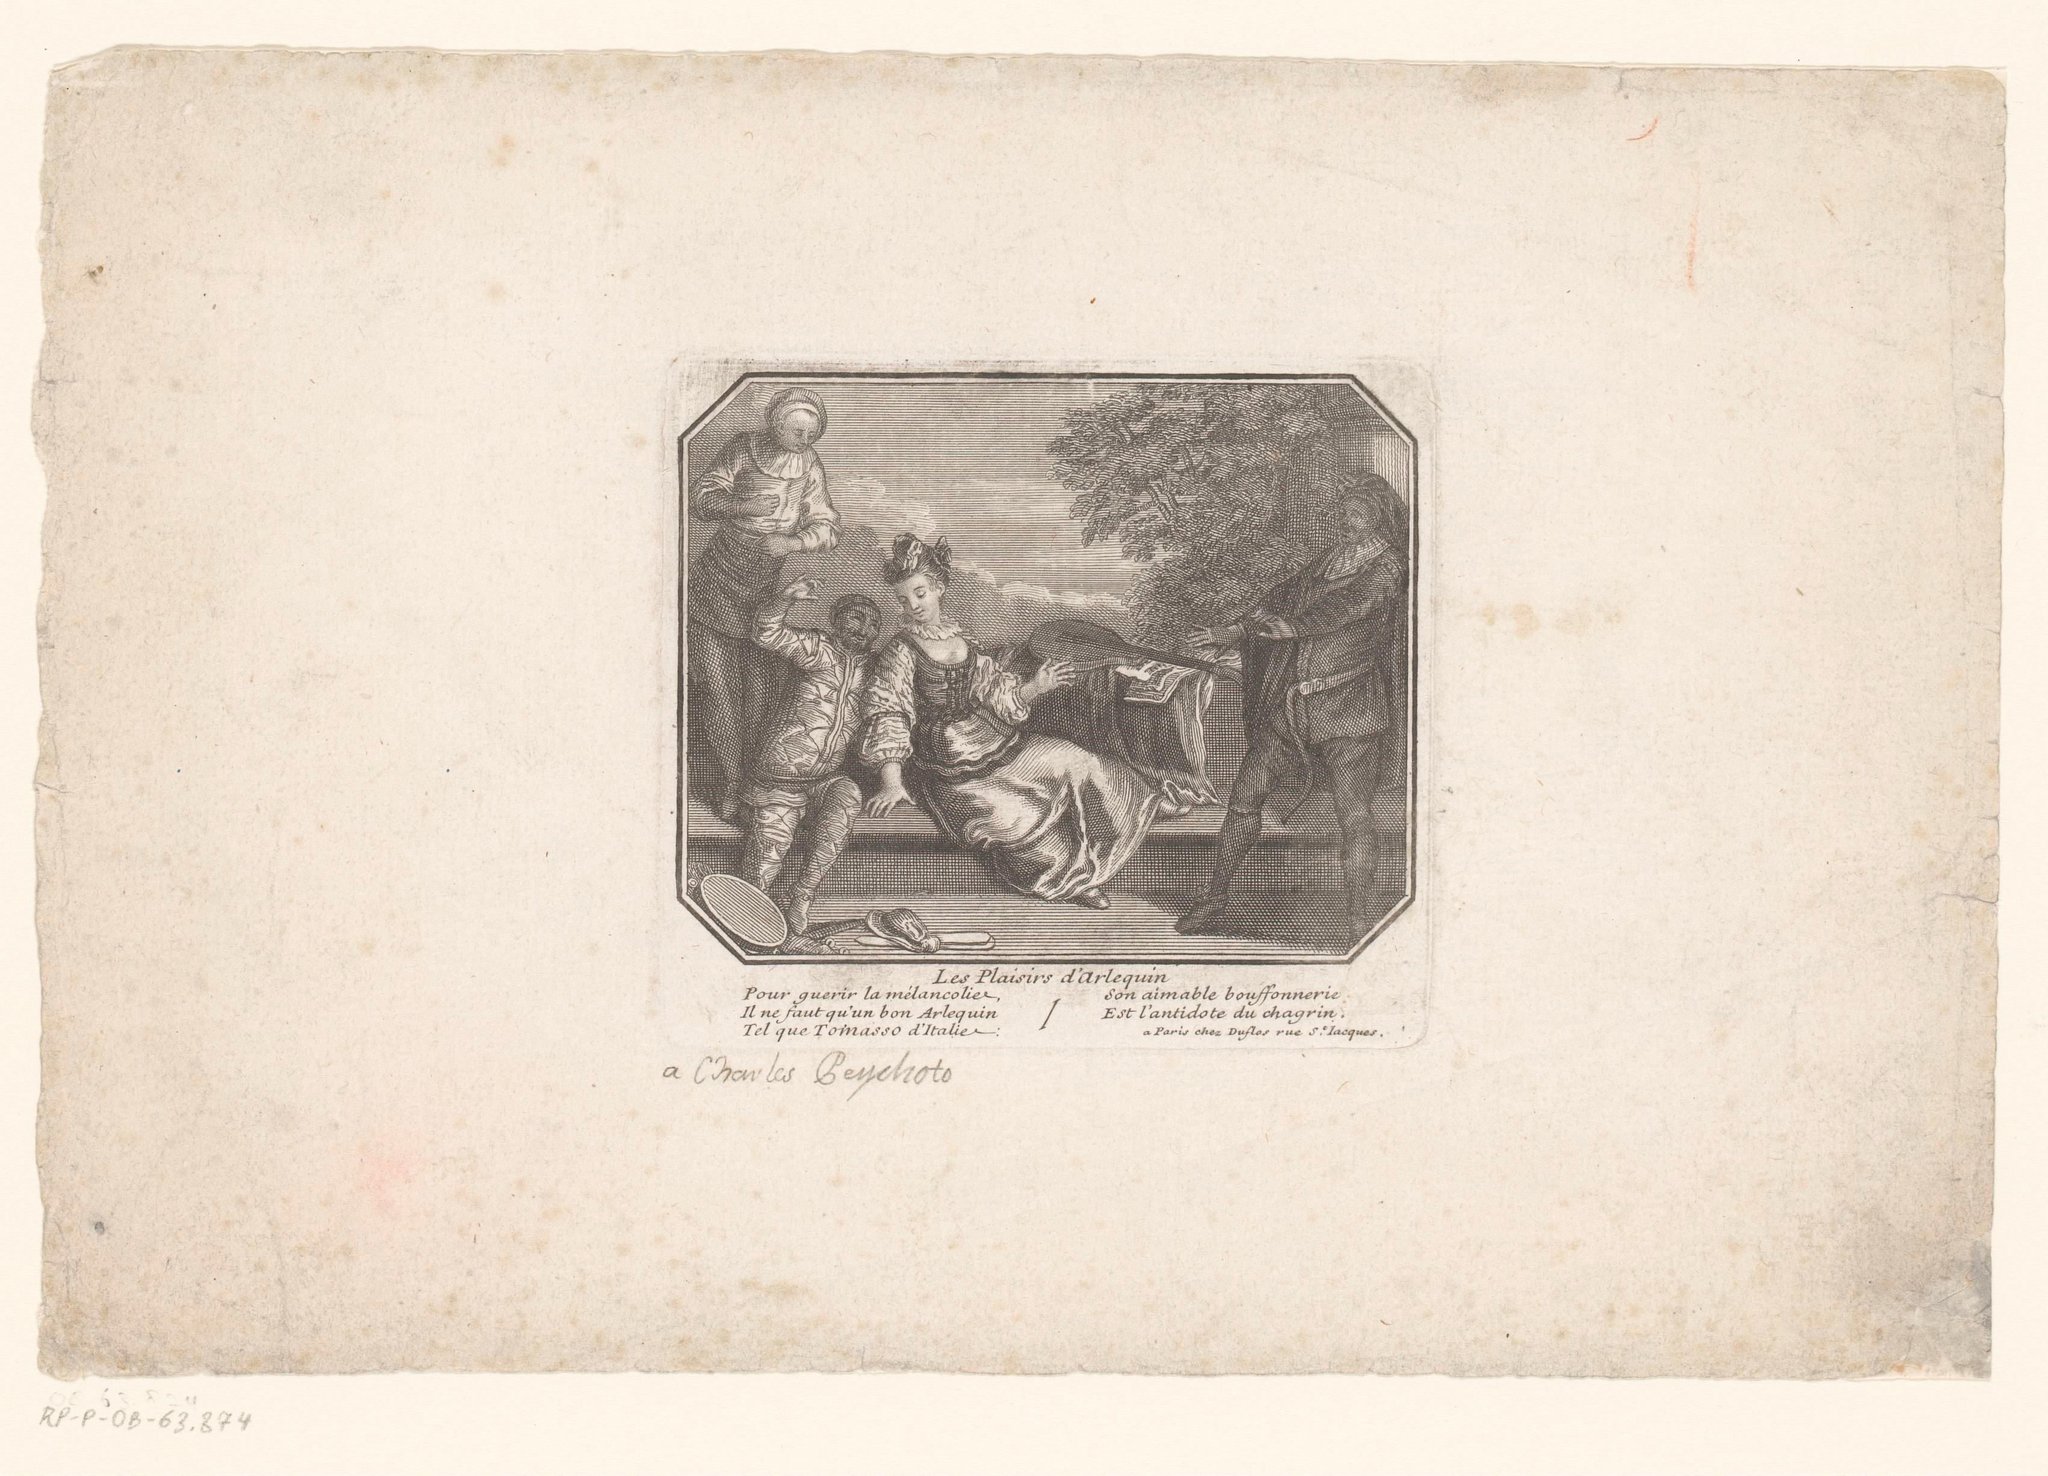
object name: print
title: Les Plaisirs d'Arlequin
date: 1694-1727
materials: paper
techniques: engraving, etching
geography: france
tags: garden of love, court of love, 'fête galante'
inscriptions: collector's mark: Lugt 2228